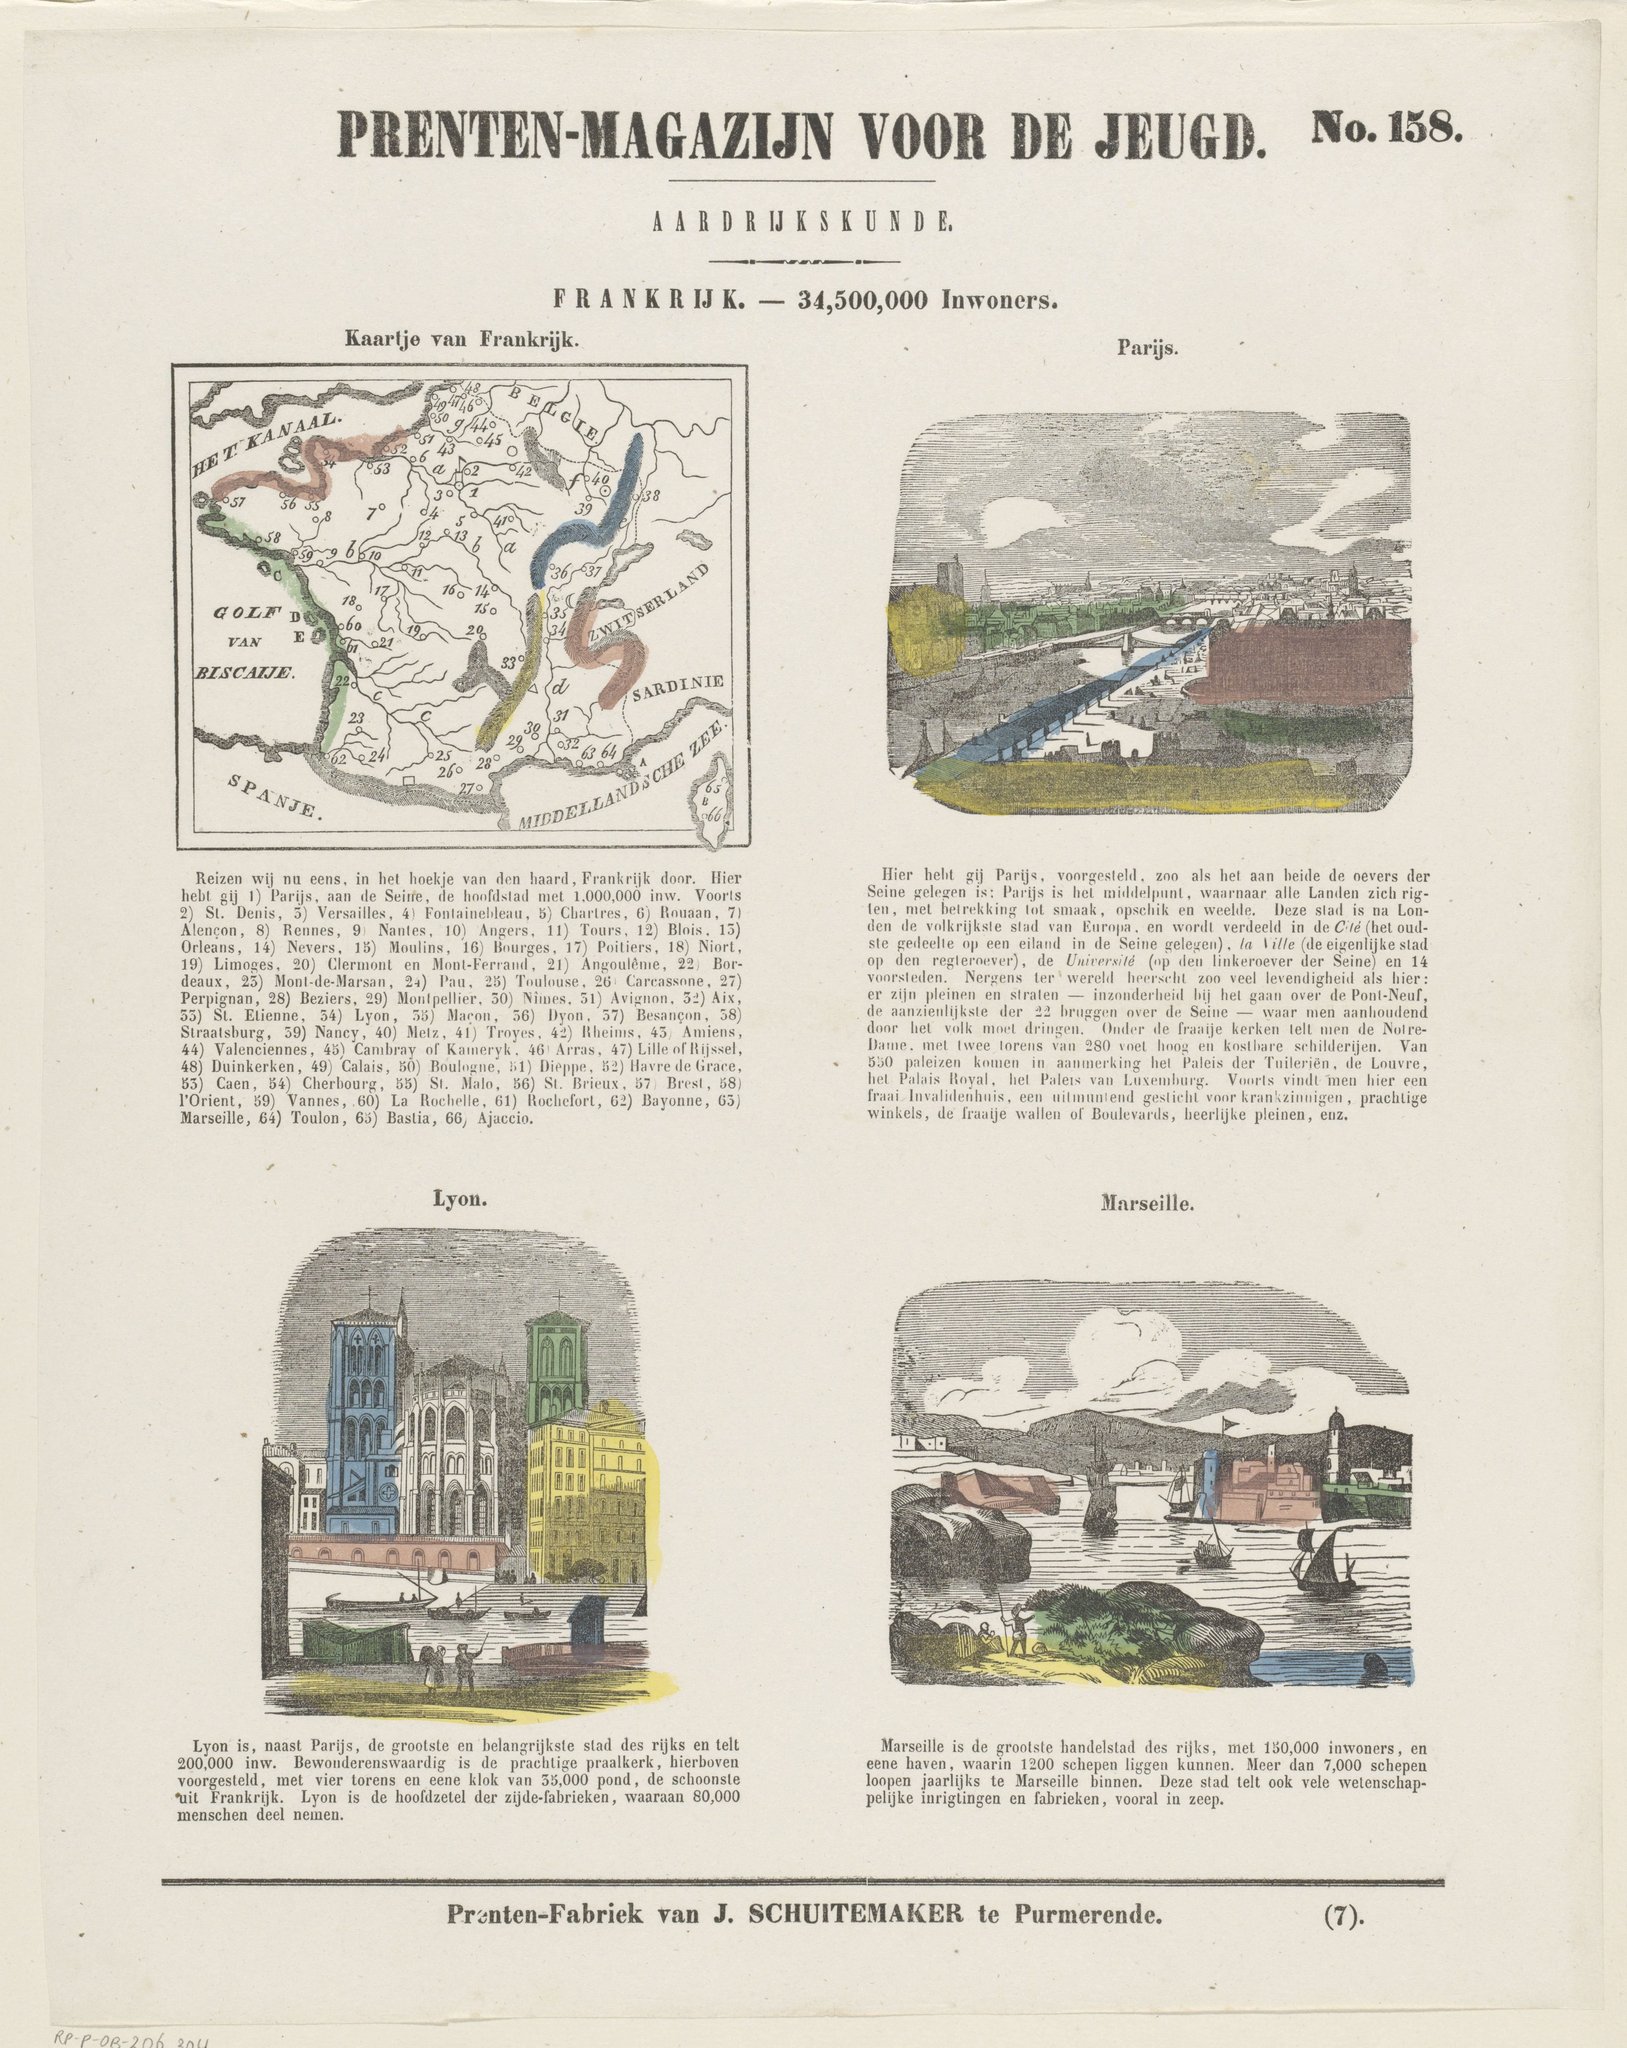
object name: print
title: Frankrijk. - 34,500,000 inwoners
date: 1850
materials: paper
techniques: colour, letterpress printing, engraving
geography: netherlands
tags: maps, atlases, france, paris, marseille, lyon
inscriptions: collector's mark: Lugt 2760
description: Na voltooiing van de acht jaargangen van de reeks 'Prenten-magazijn voor de jeugd' in 1850 heeft Jan Schuitemaker al deze prenten heruitgegeven en omgenummerd als nr. 1 t/m 192. De oorspronkelijke jaargang wordt telkens nog vermeld rechtsonder op de prent. Binnen de jaargangen zijn prenten van hetzelfde thema in clusters van vier achter elkaar gezet.